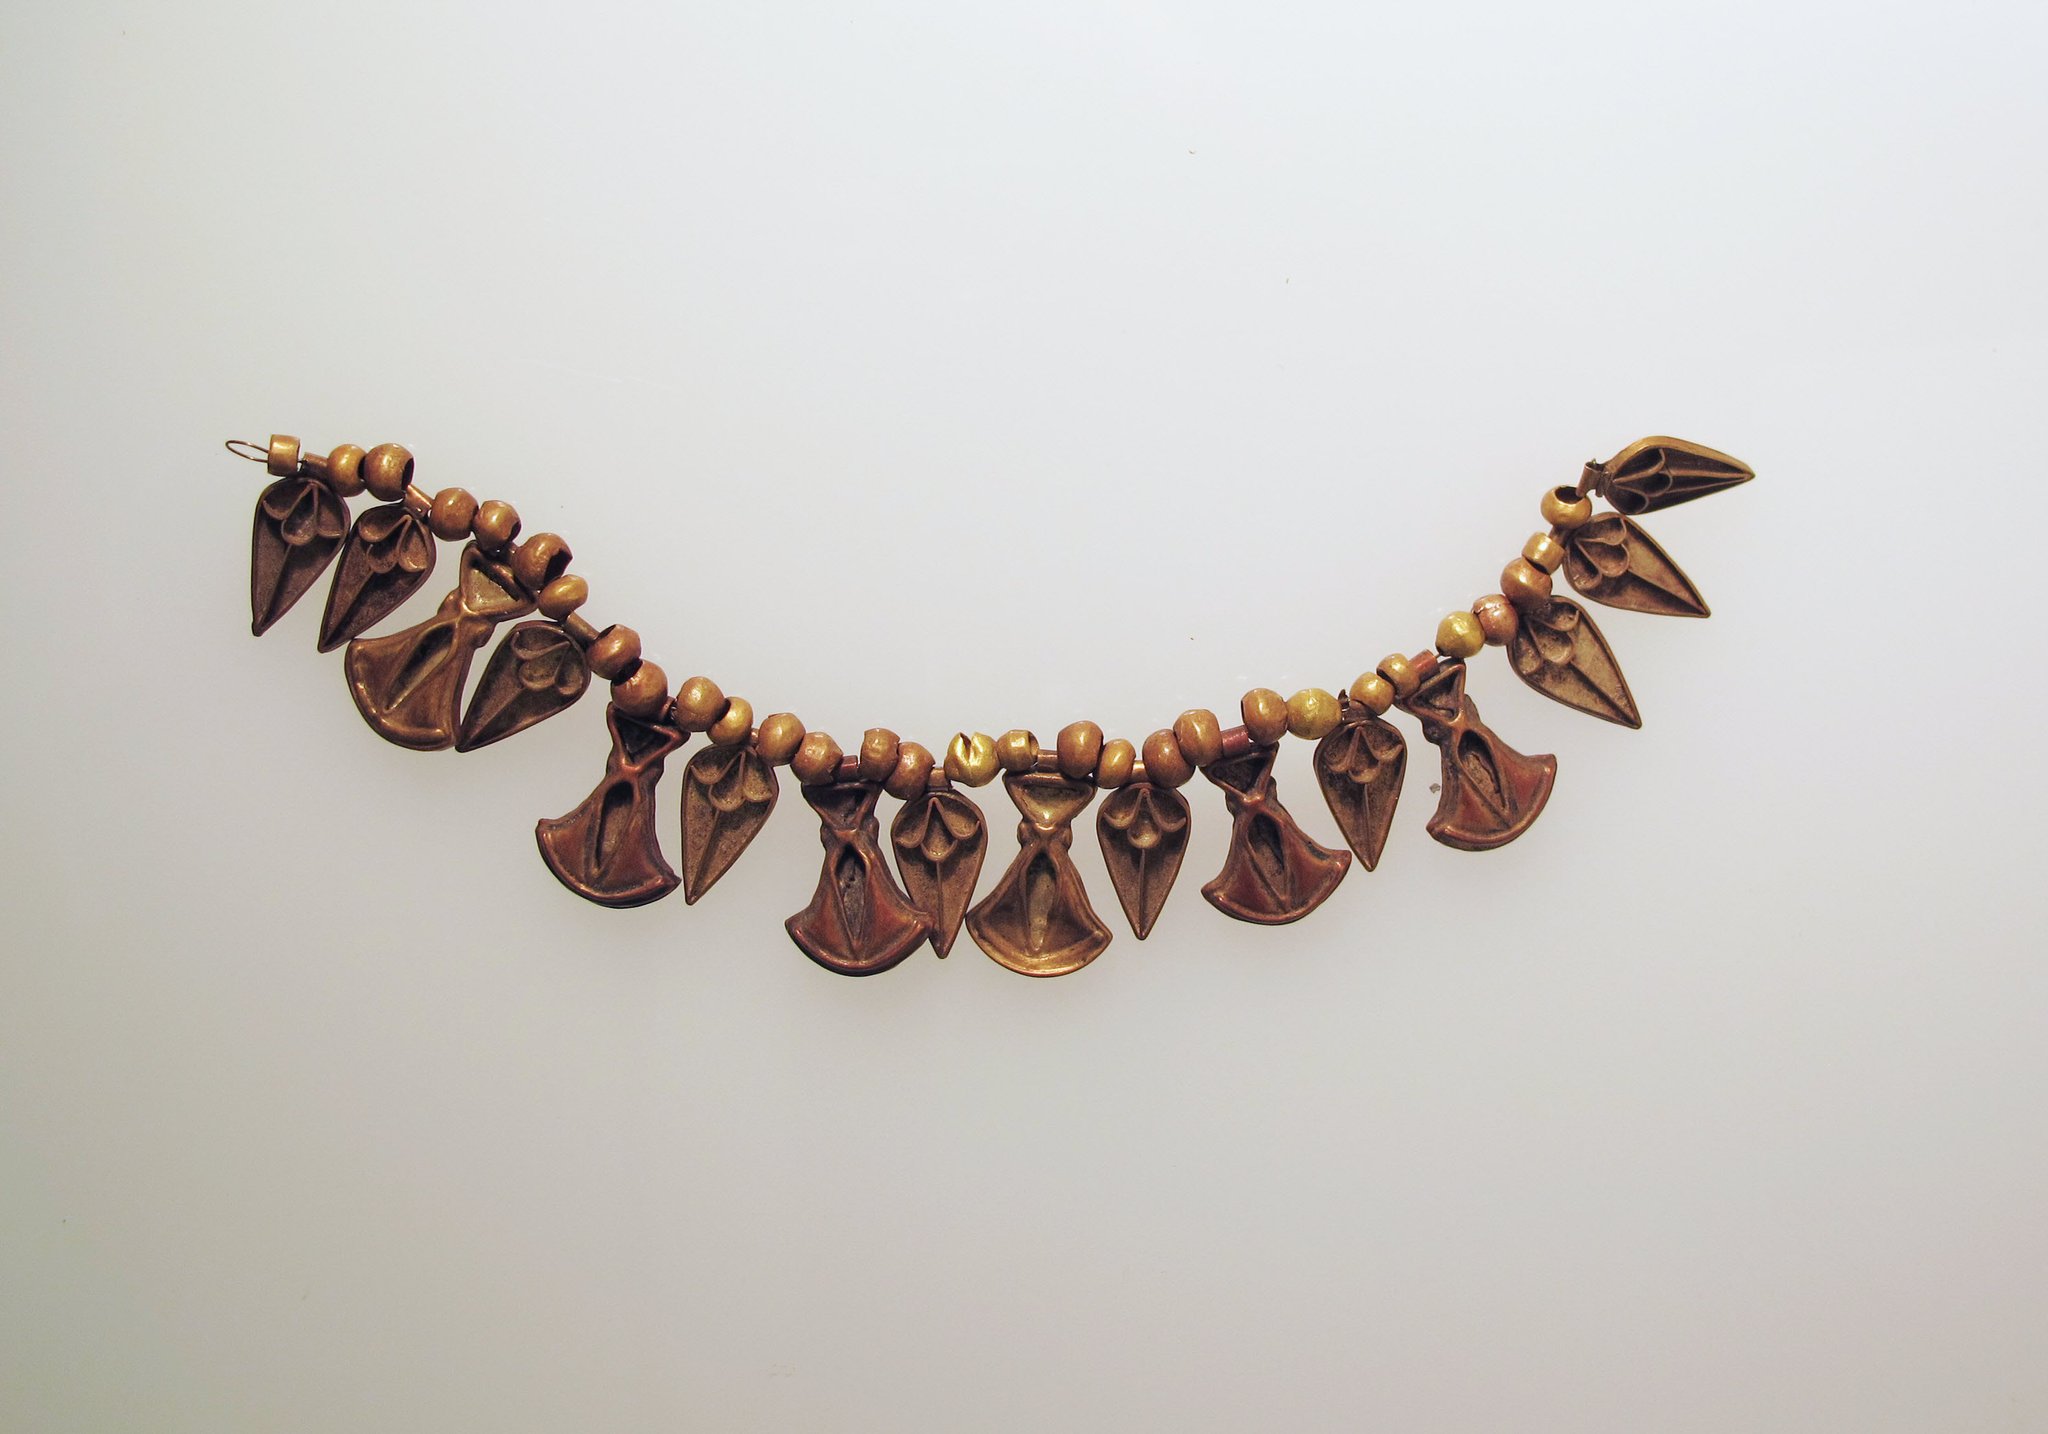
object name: bead pendant, with lotus flower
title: Bead pendant, with lotus flowers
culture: cypriot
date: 3900 BCE-100 CE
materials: gold